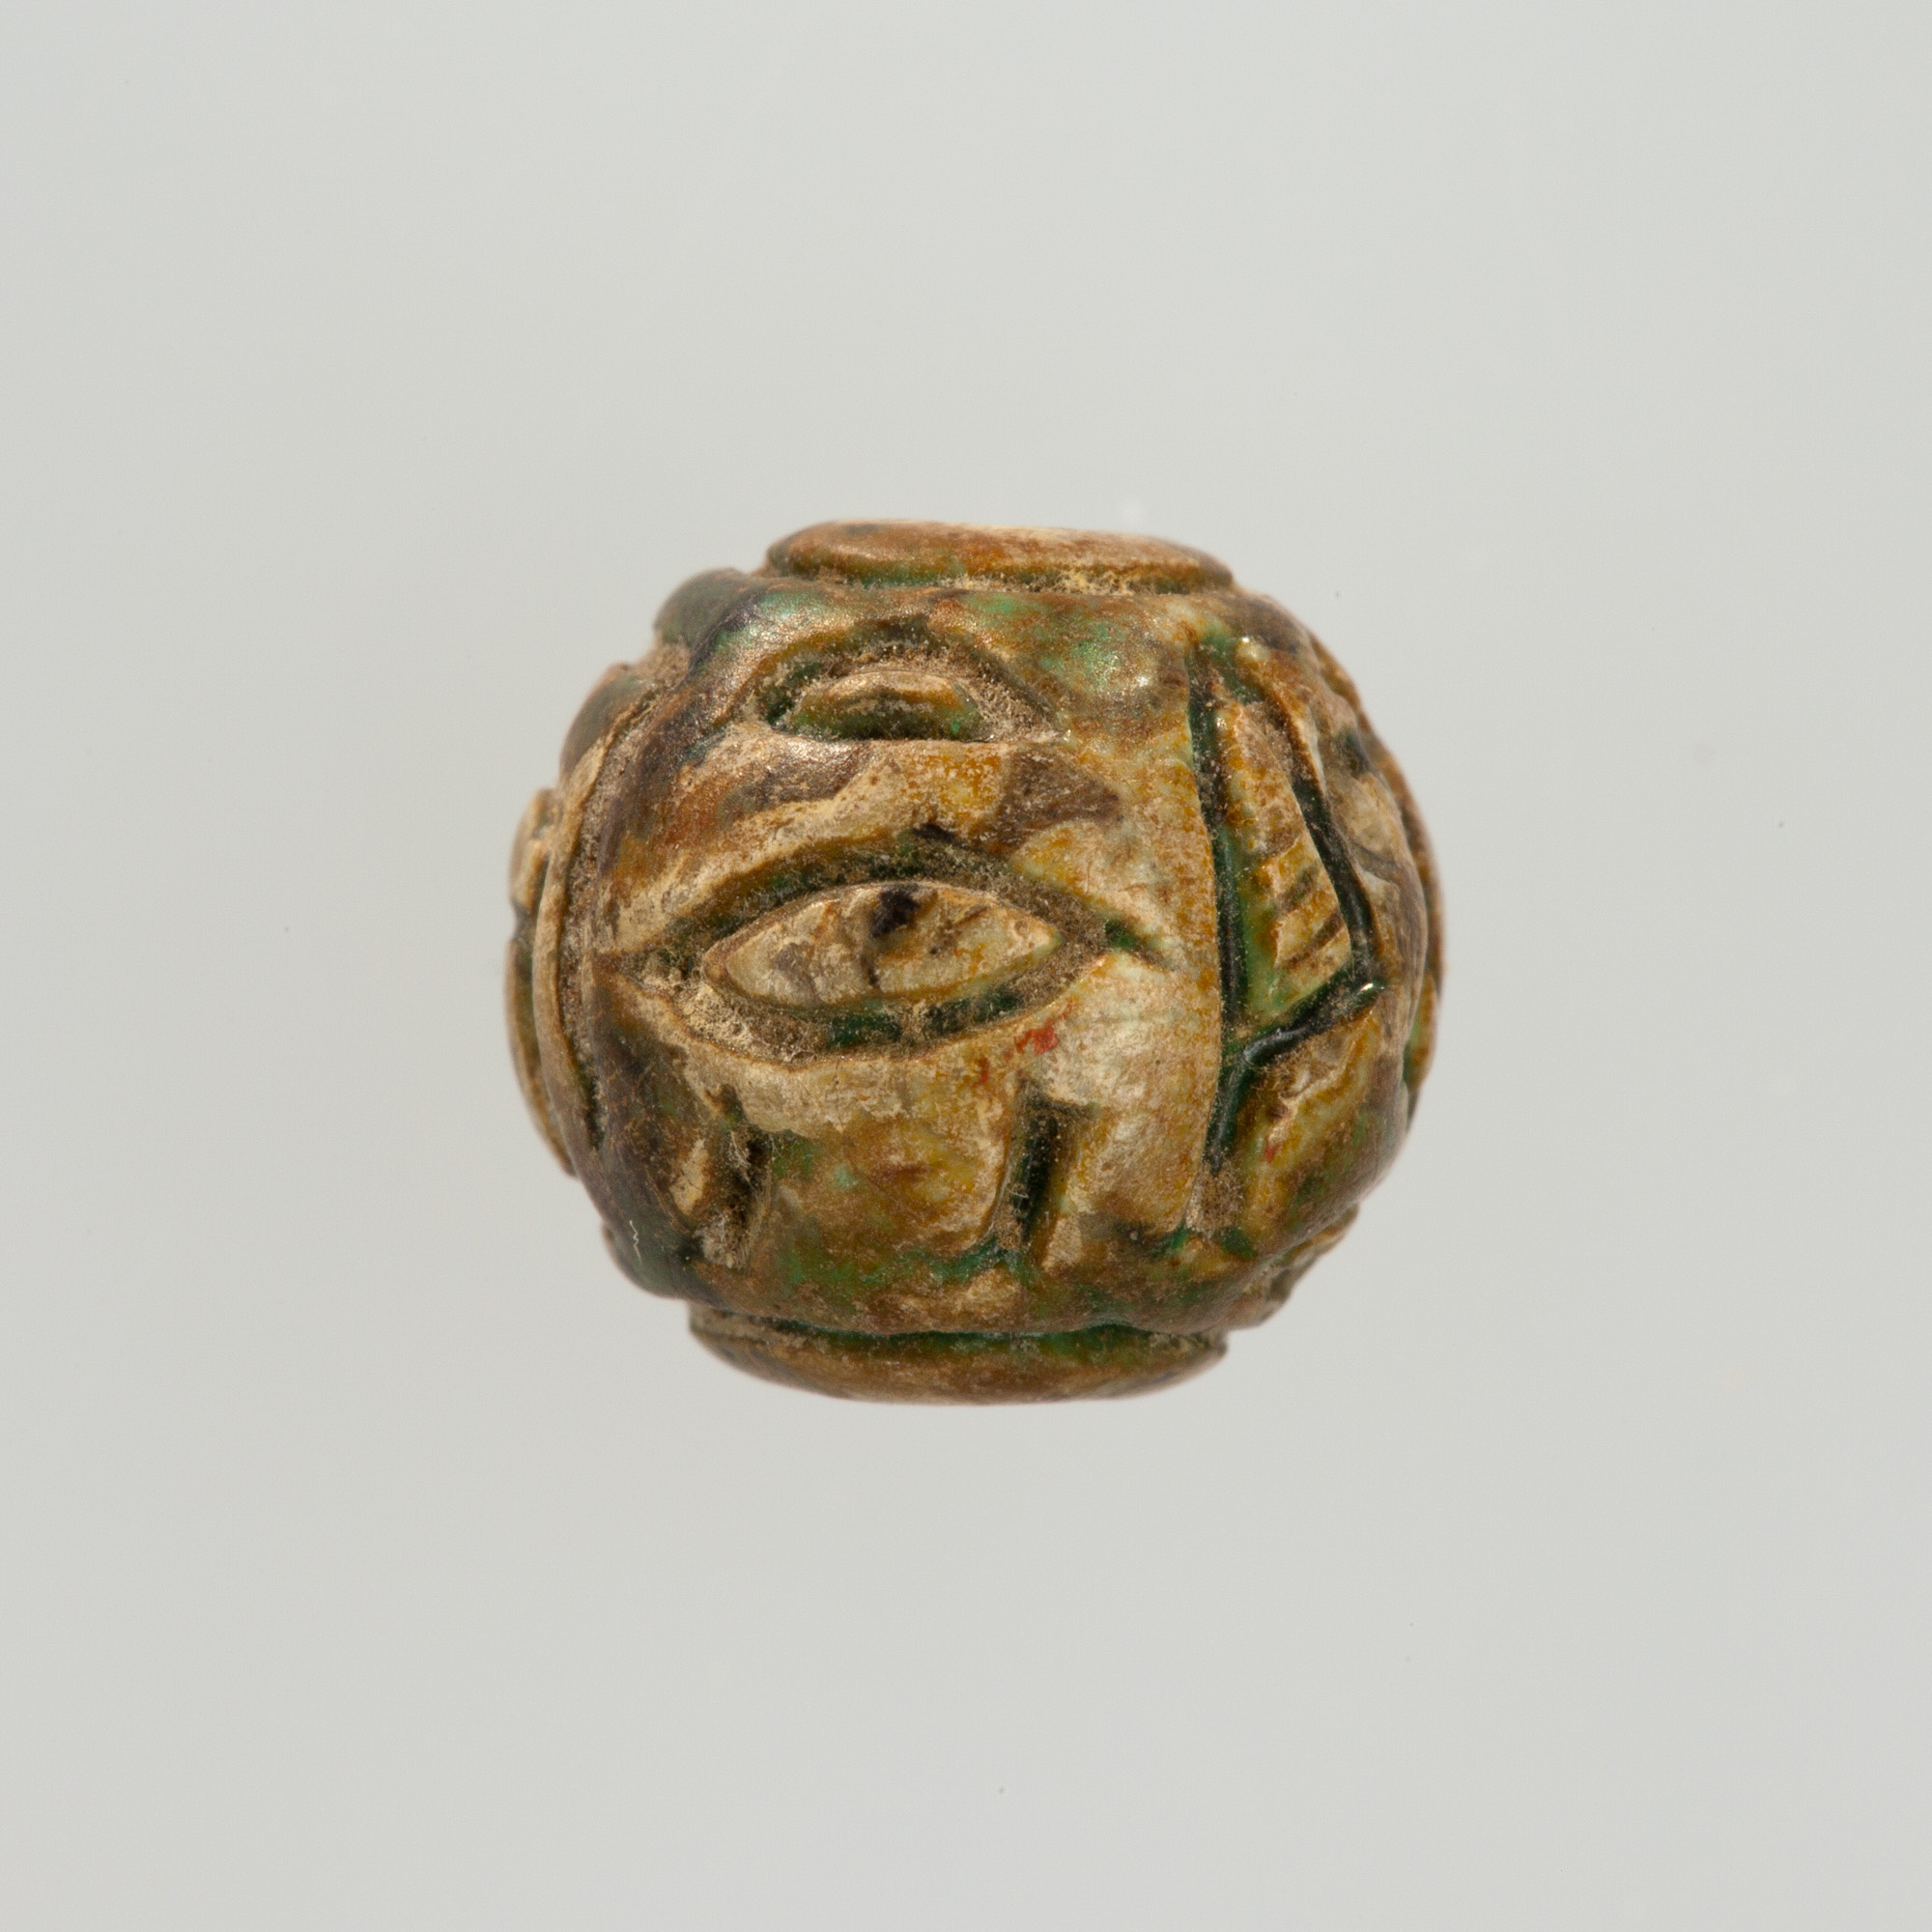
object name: bead, ahmose nefertari, united with the white crown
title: Bead Inscribed (Ahmose-)Nefertari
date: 1550-1479 BCE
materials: stone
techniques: glazing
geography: egypt